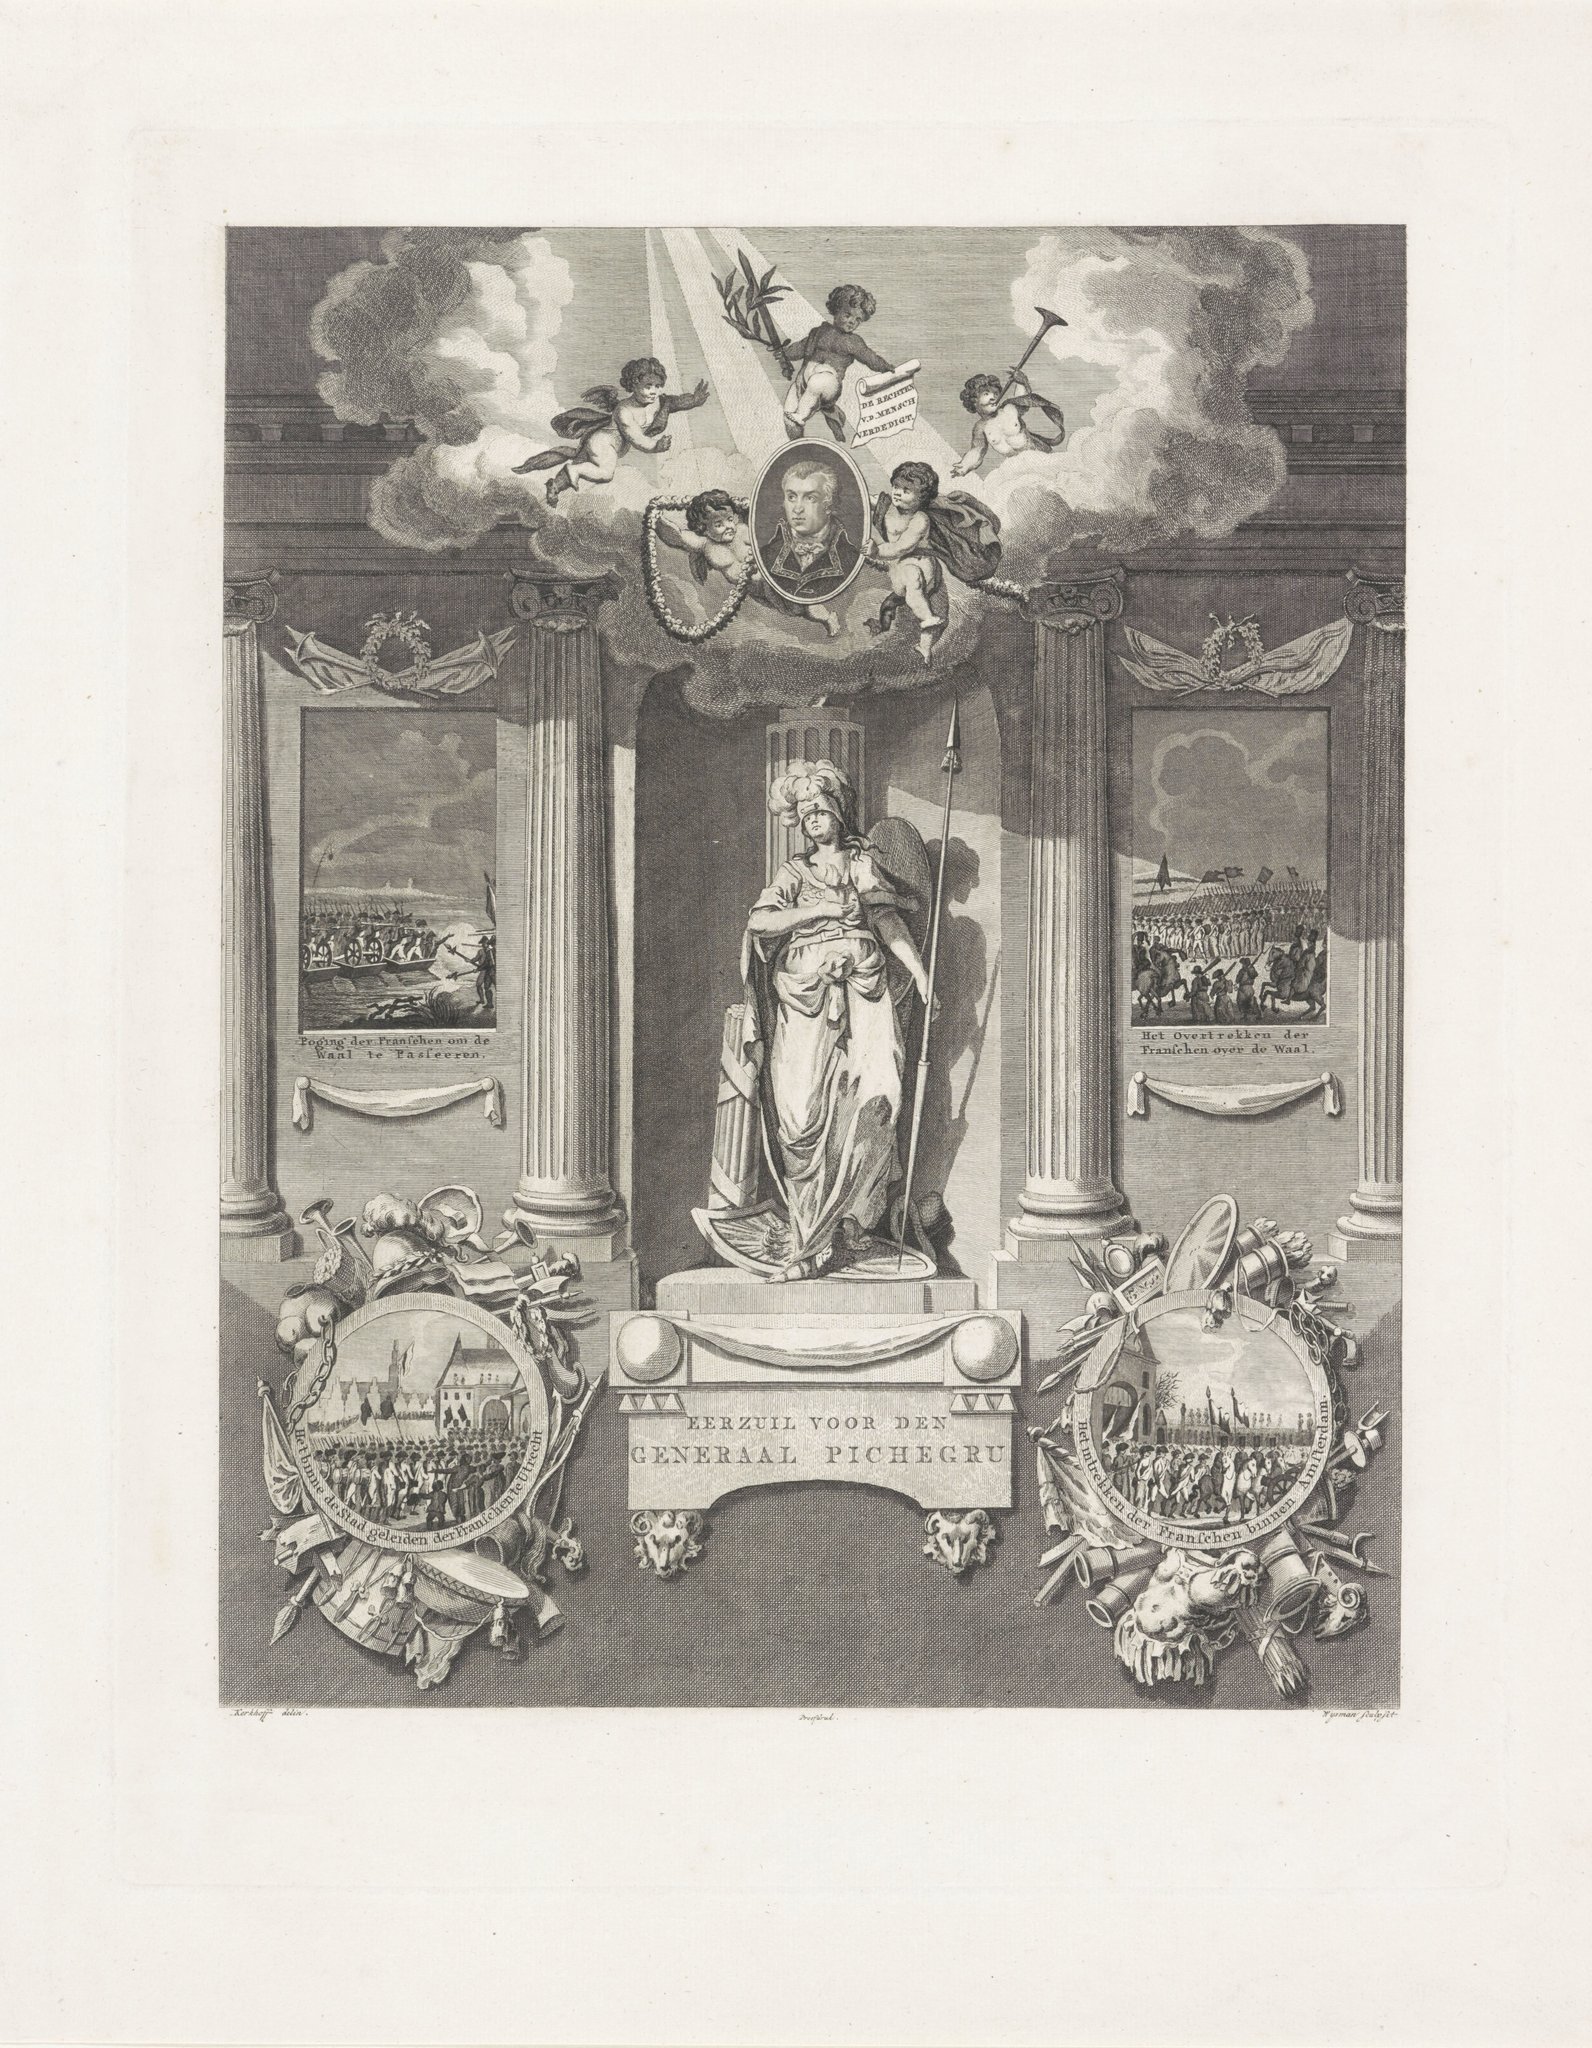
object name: print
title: Monument voor generaal Pichegru, 1795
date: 1795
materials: paper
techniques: engraving, etching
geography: northern netherlands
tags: paris, politician, jean-charles pichegru, freedom, liberty; 'libertà' (ripa) (+ abstract concept represented by female figure), utrecht, amsterdam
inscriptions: collector's mark: Lugt 2228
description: Allegorisch monument voor de Franse generaal Pichegru. Centraal een standbeeld van de Vrijheid, bovenaan putti met een portret van Pichegru. Aan weerszijden cartouches met episodes uit de inval van de Fransen in 1795: het oversteken van de Waal en binnentrekken van Utrecht en Amsterdam.